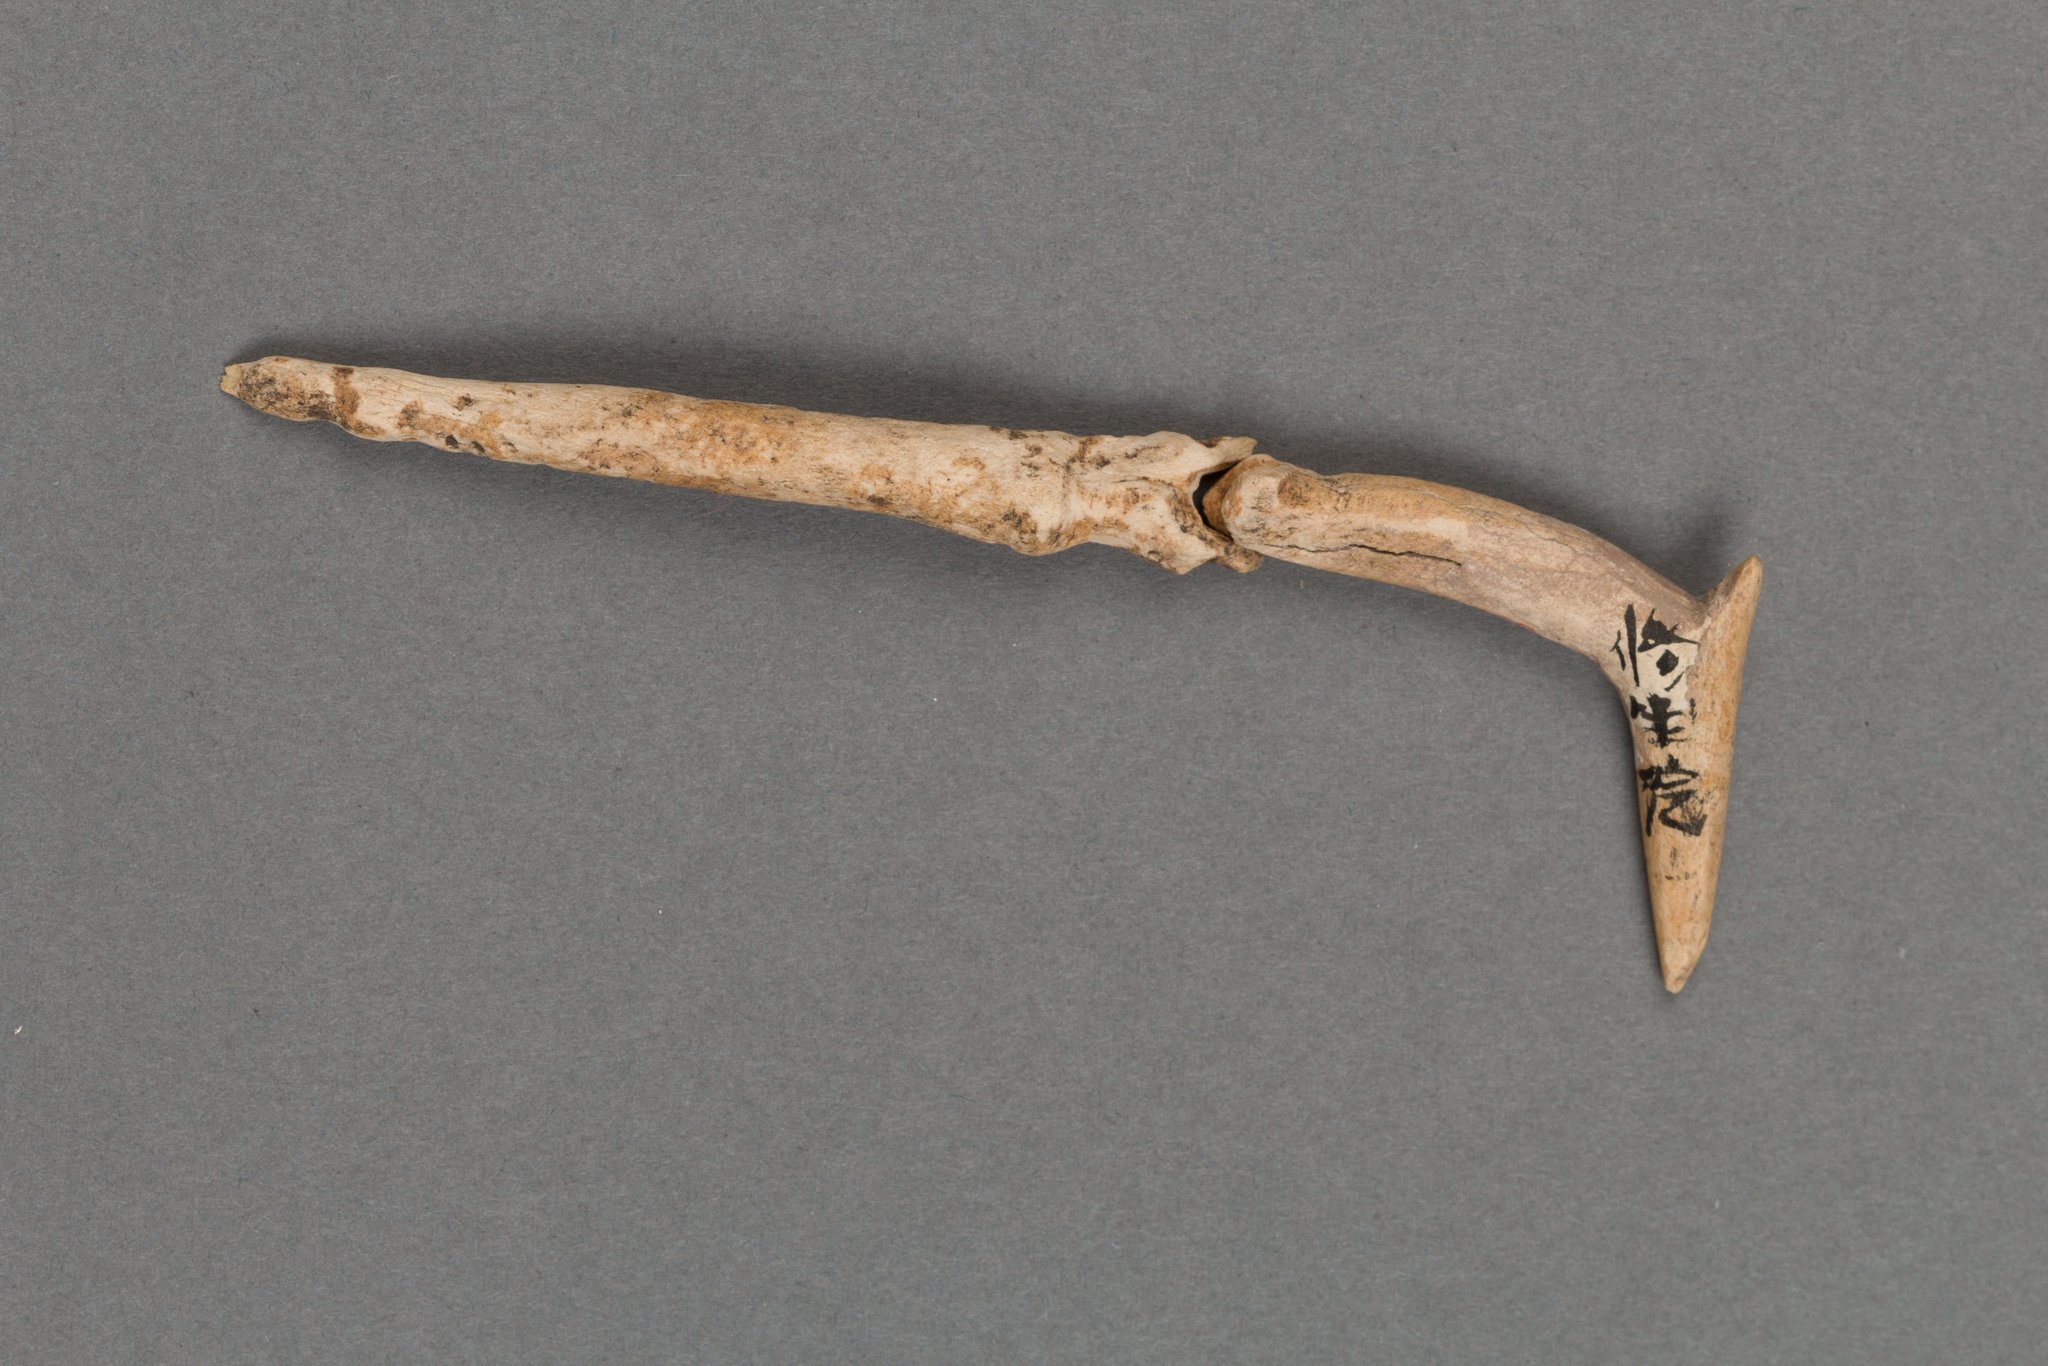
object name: fish hook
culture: japanese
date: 1200-200 BCE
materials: bone